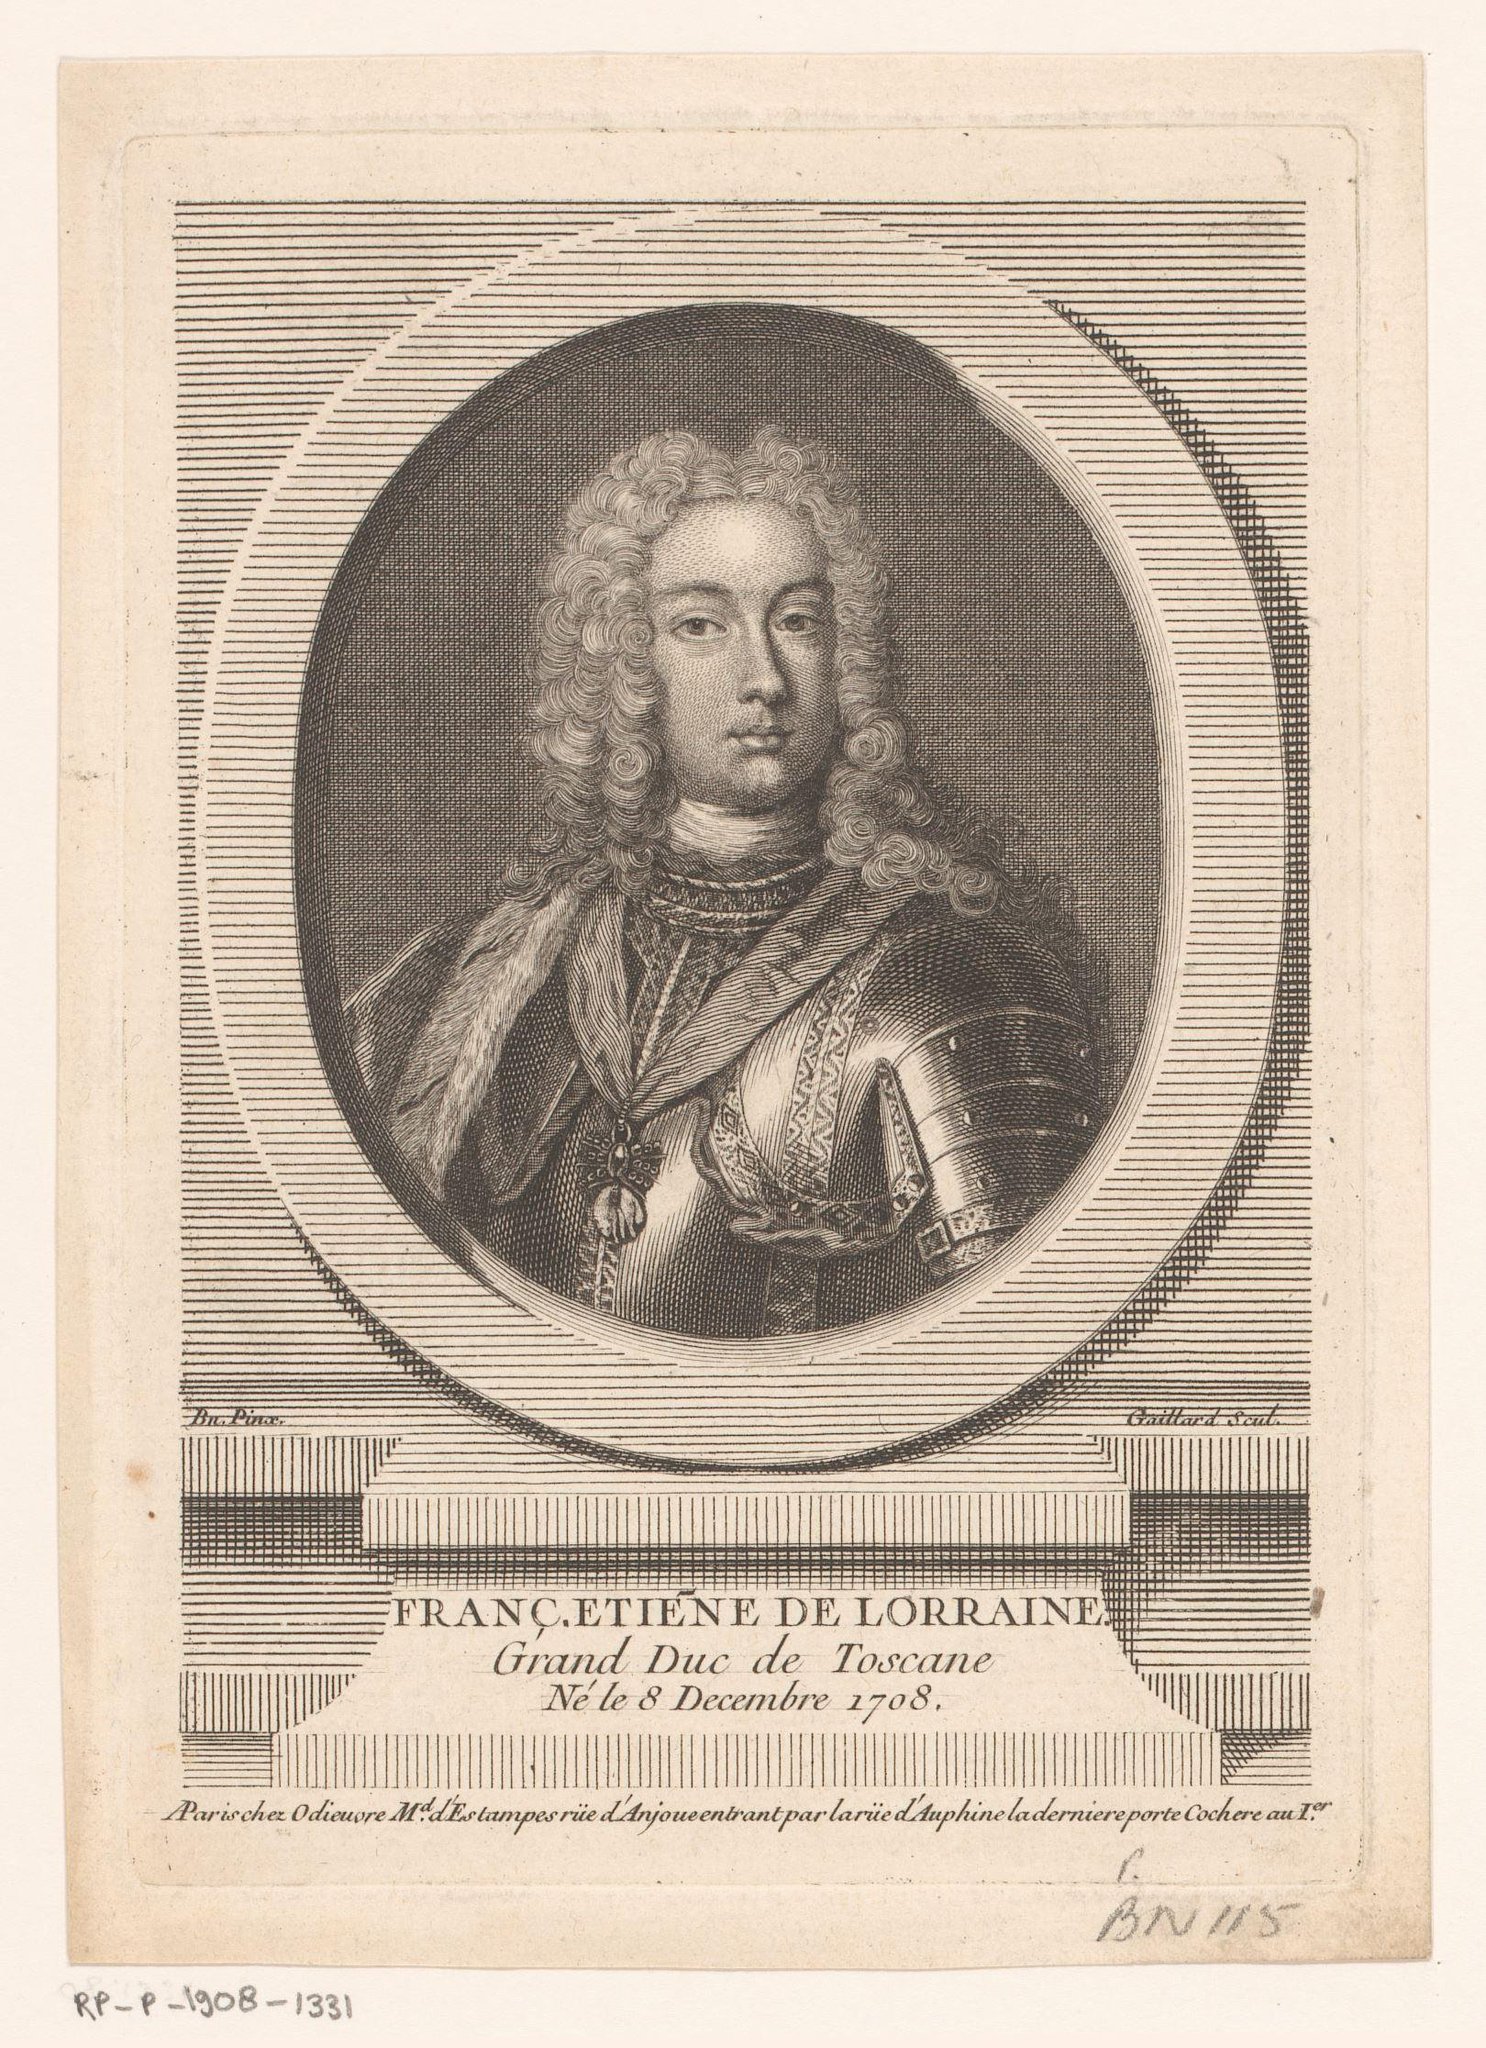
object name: print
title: Portret van Frans I Stefan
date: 1744-1765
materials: paper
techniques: engraving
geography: paris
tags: frans i stefan (duits keizer), historical persons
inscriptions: collector's mark: Lugt 2228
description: Mogelijk prent uit: Dreux du Radier, Jean-François. L'Europe illustré, contenant l'histoire abregée des souverains, des princes, des prélats, des ministres, (...) en Europe: dans le XVe. siècle compris, jusqu'à présent. Parijs: Michel Odieuvre en André-François Le Breton, 1755-1765, dl. 4.